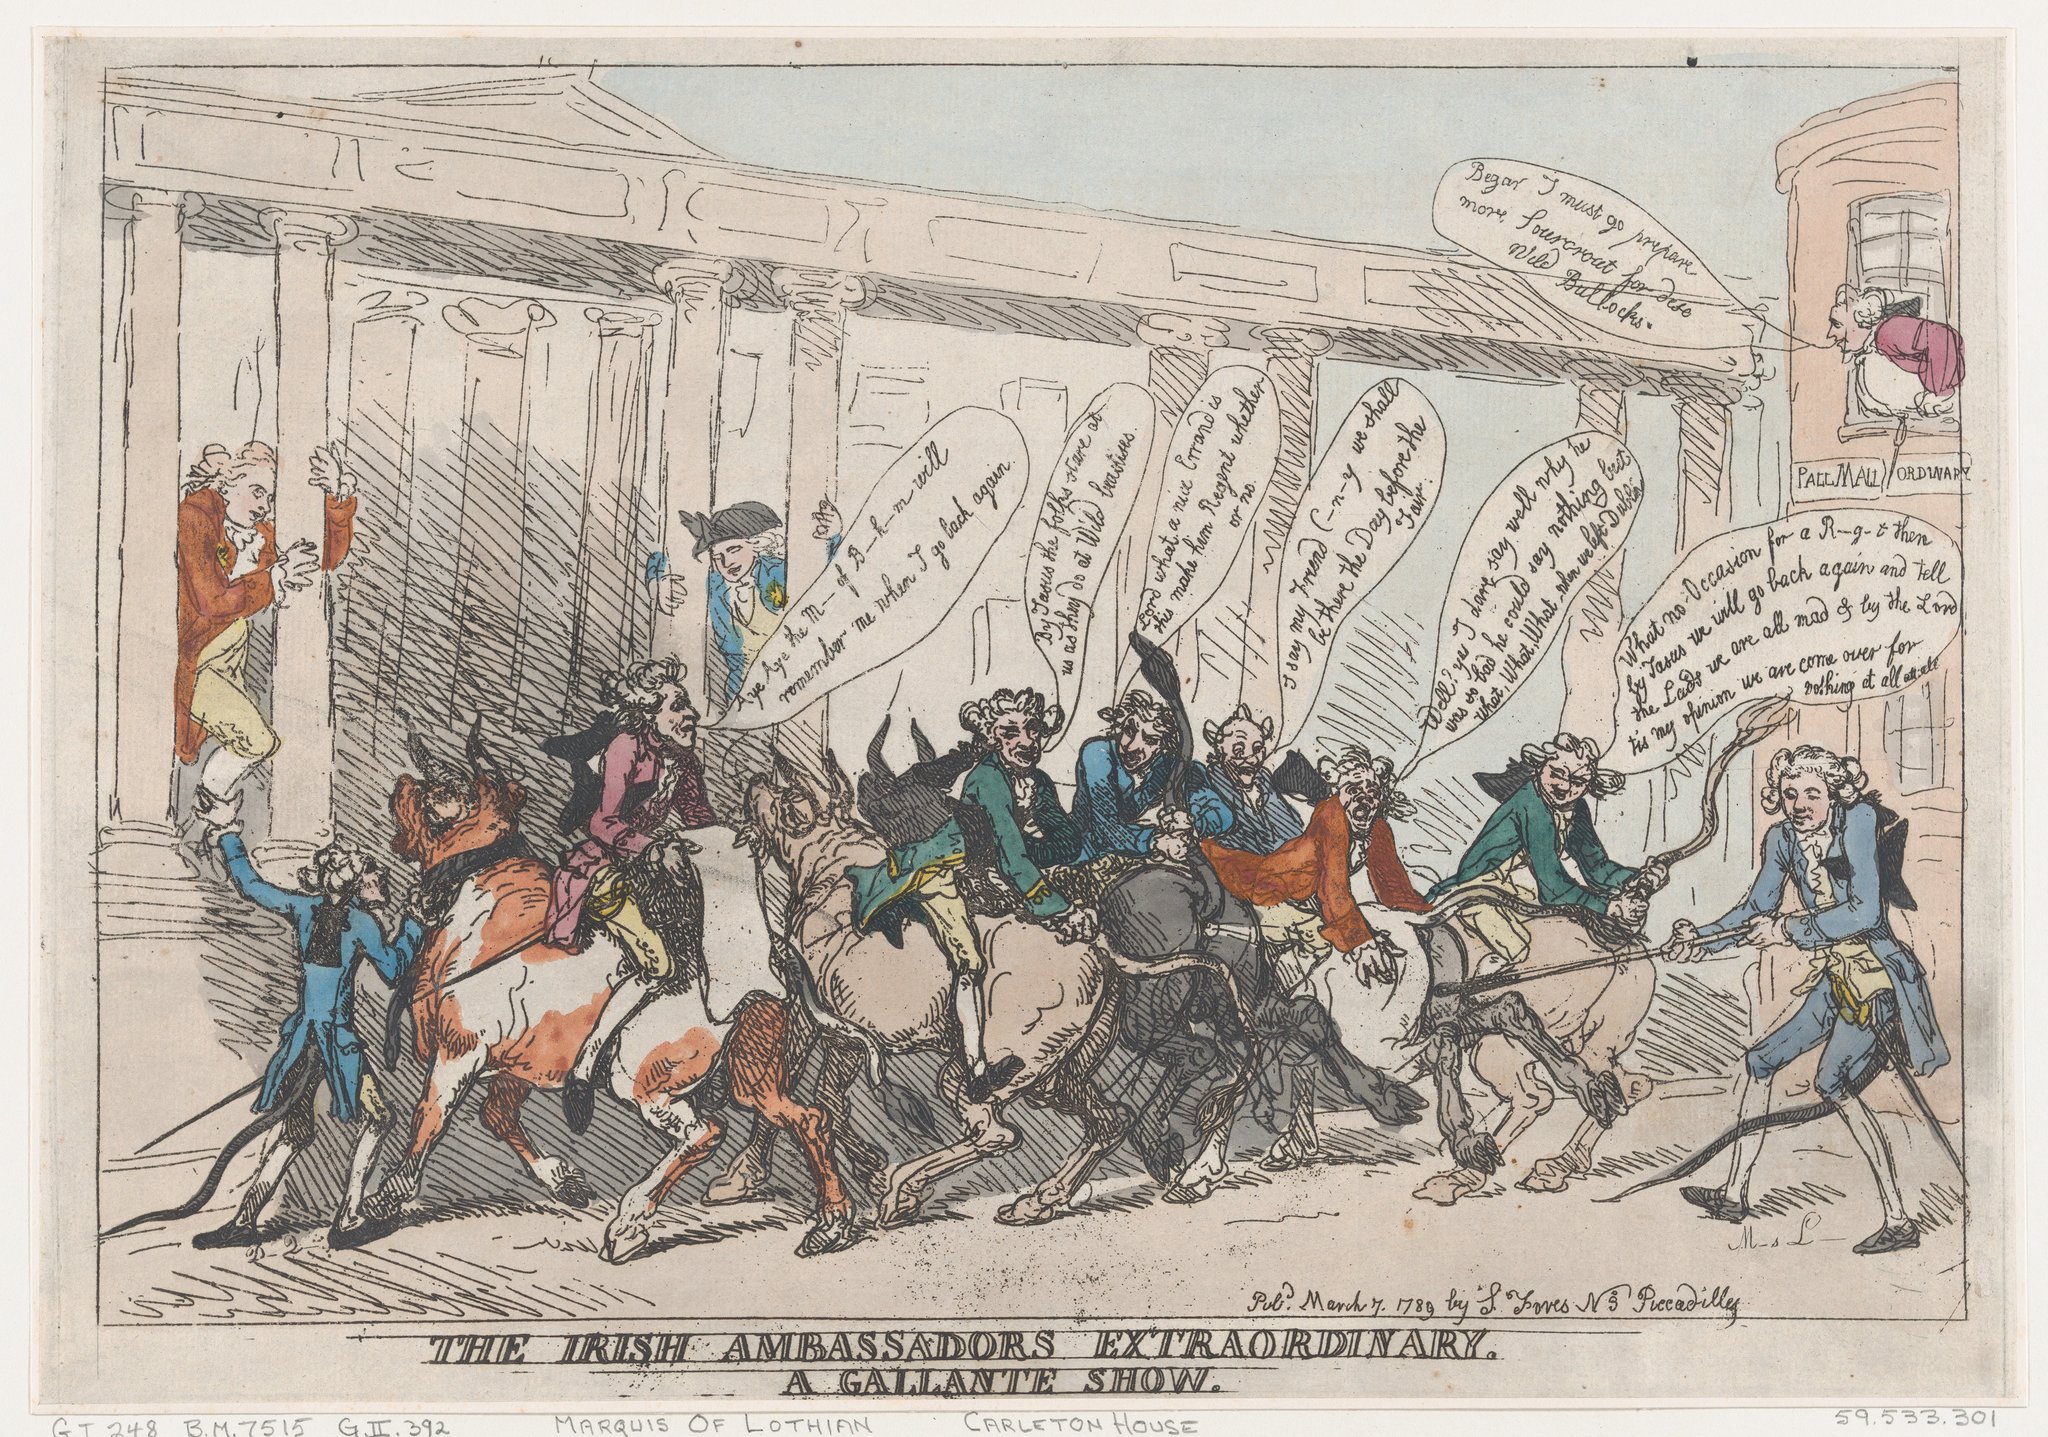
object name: print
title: The Irish Ambassadors Extraordinary, A Gallante Show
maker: thomas rowlandson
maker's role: artist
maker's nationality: british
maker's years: 1757-1827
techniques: etching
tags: satire,buildings,men,bulls